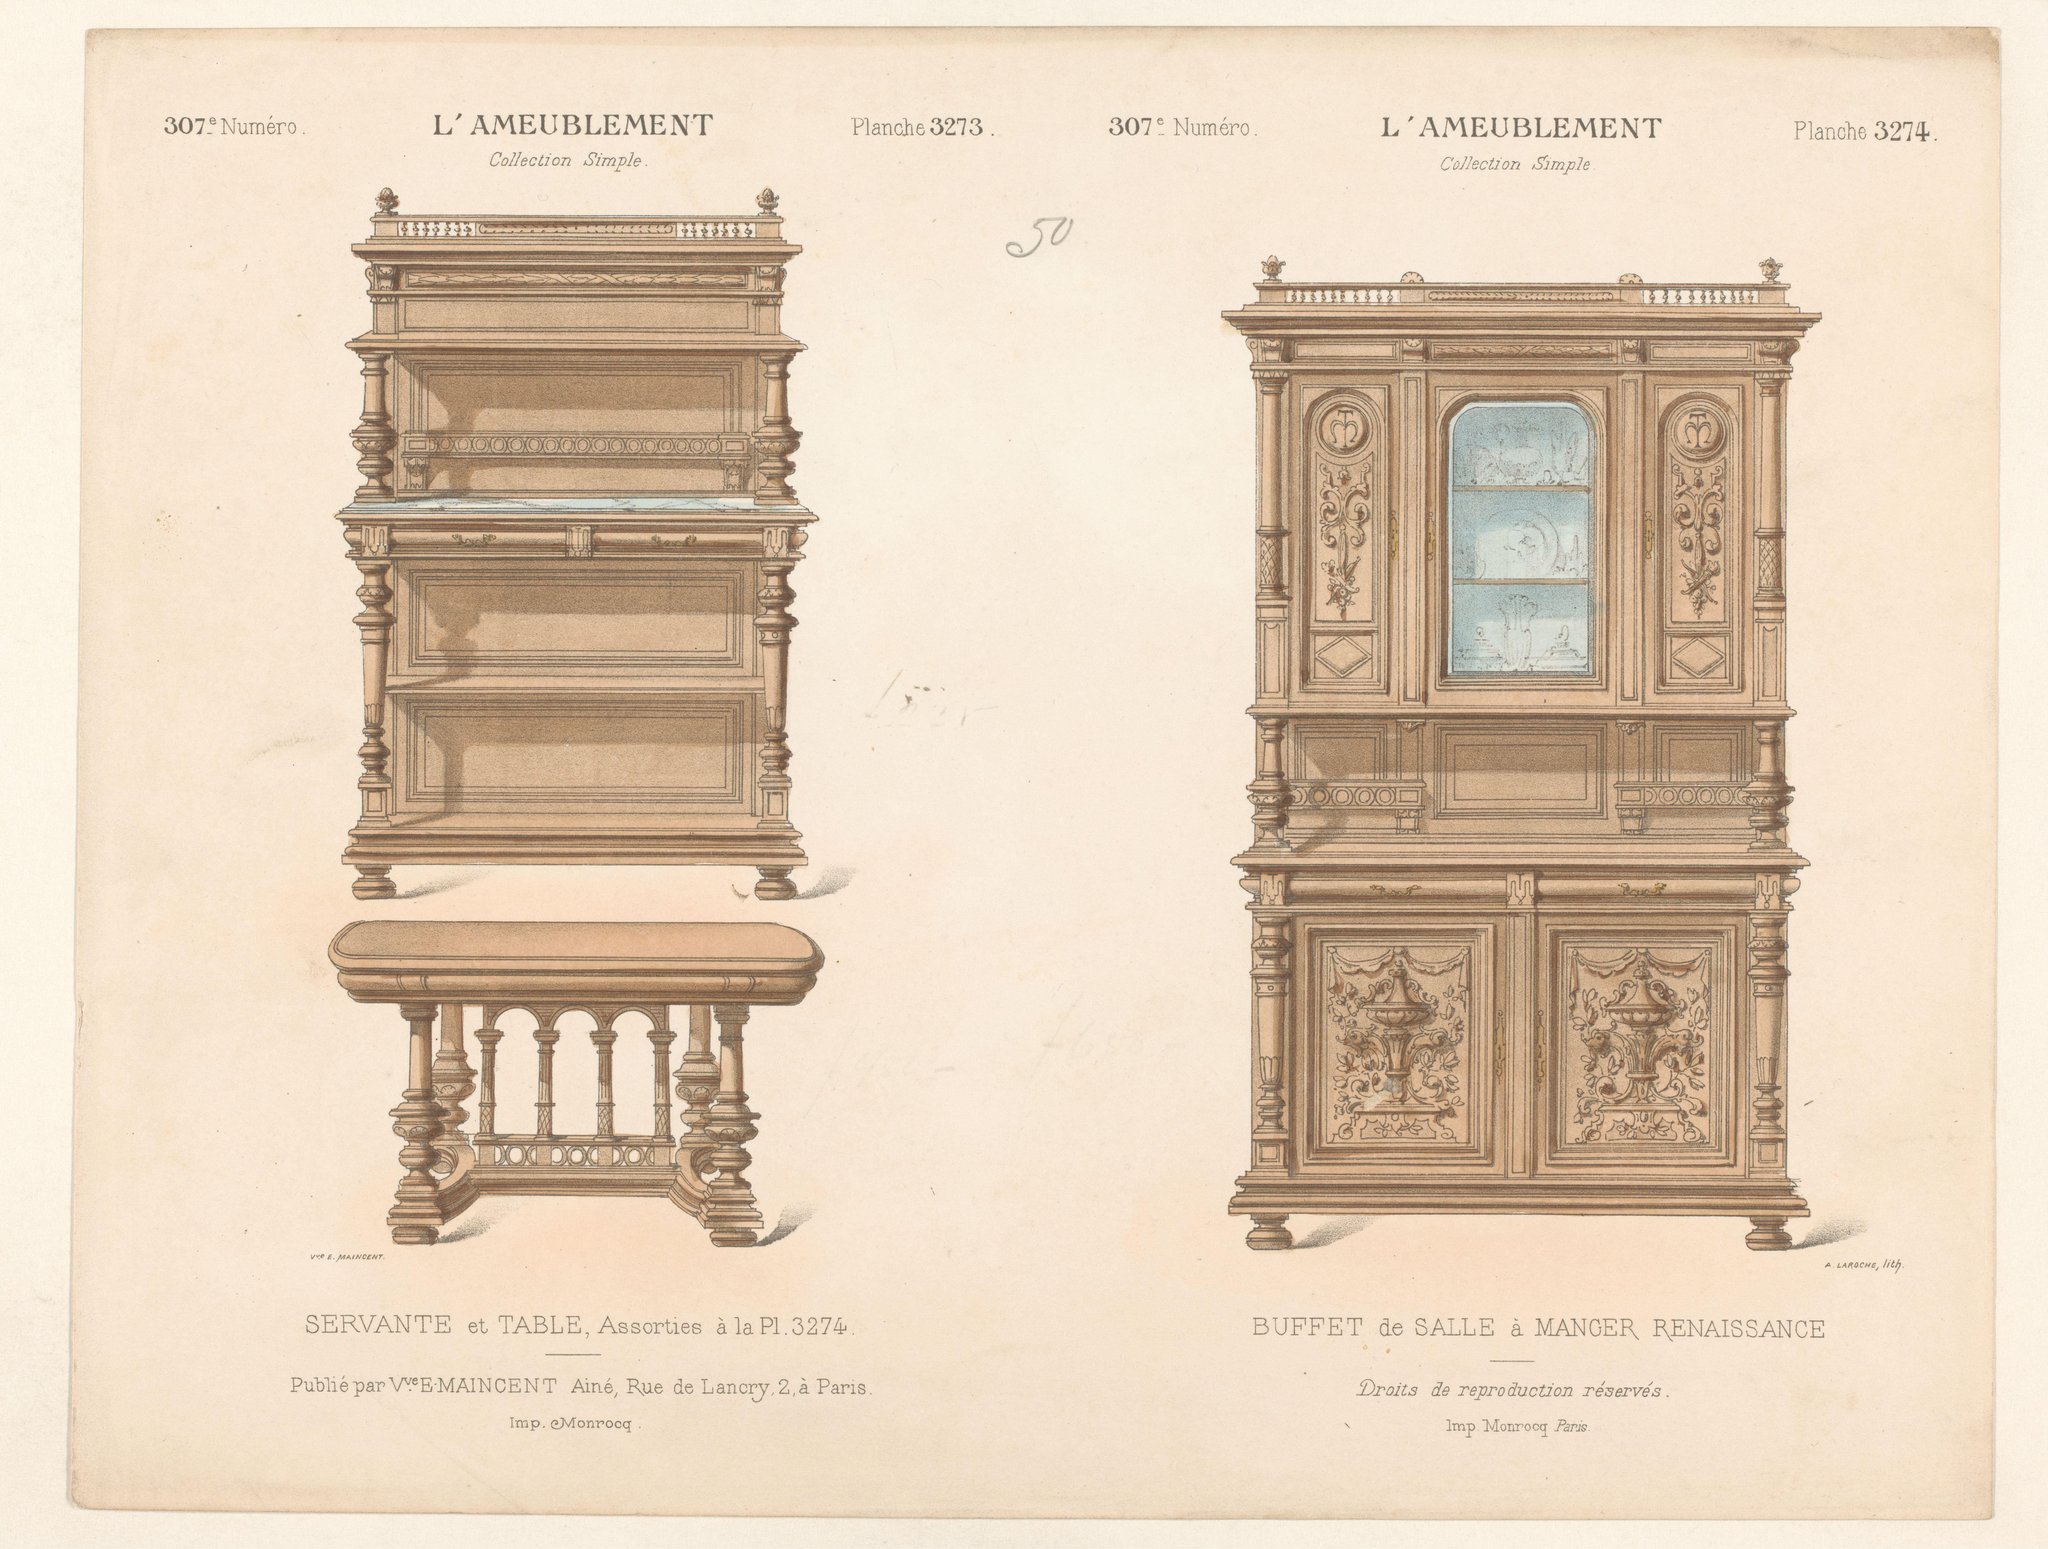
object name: print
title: L'ameublement / Collection Simple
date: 1895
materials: paper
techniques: hand coloring, lithograph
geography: paris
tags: furniture for storage, table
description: Een renaissance open kast, tafel en buffetkast. Prent uit 307e Livraison.